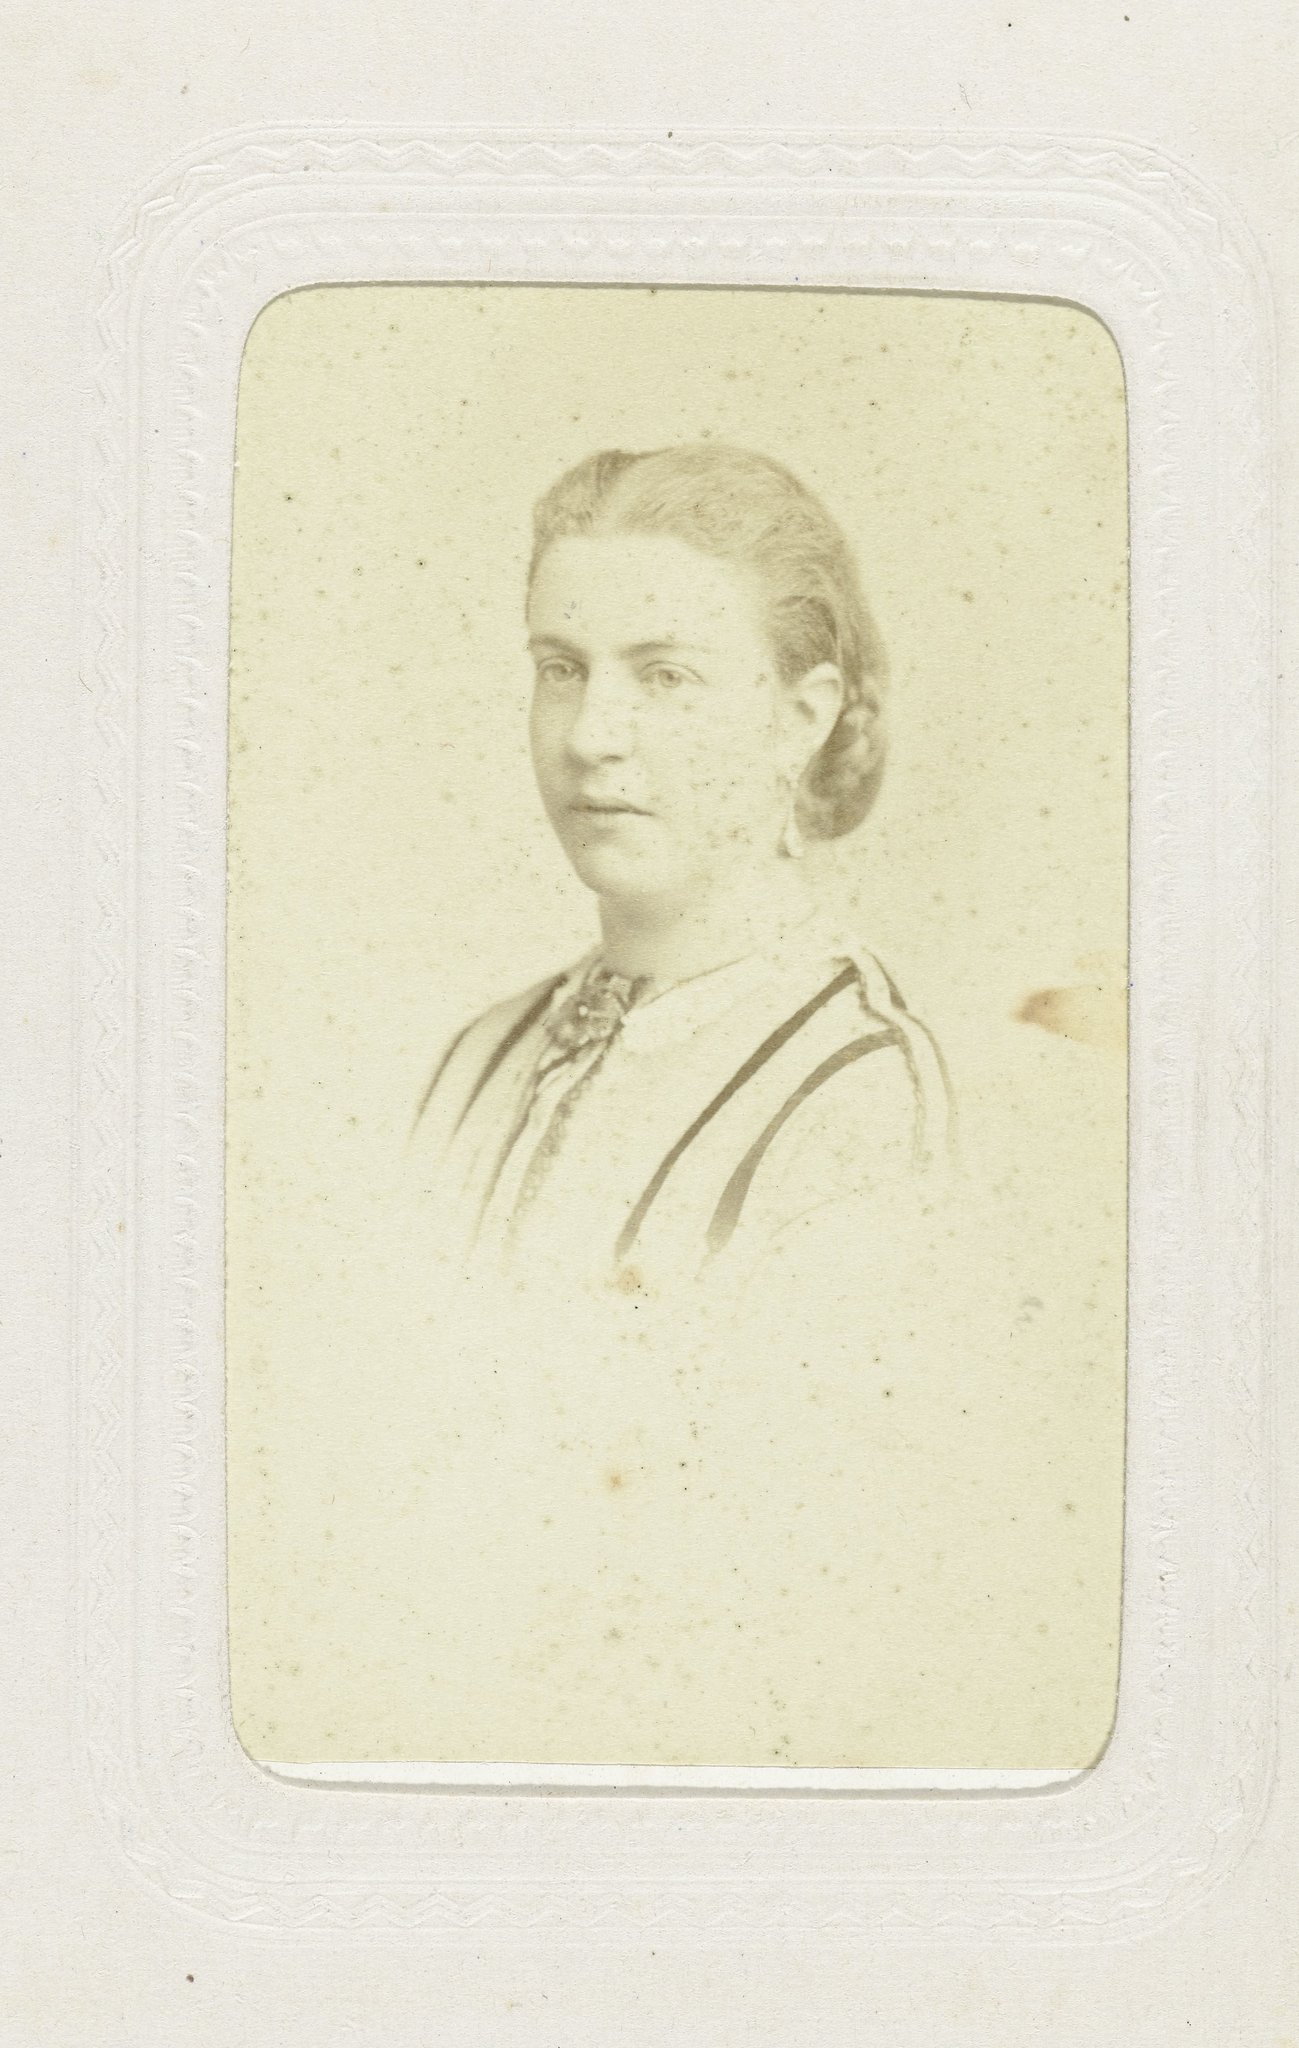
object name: carte de visite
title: Studioportret van een vrouw met opgestoken haar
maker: charles reutlinger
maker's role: publisher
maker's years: 1816-1880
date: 1863-1870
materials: cardboard, paper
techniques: albumen print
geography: paris